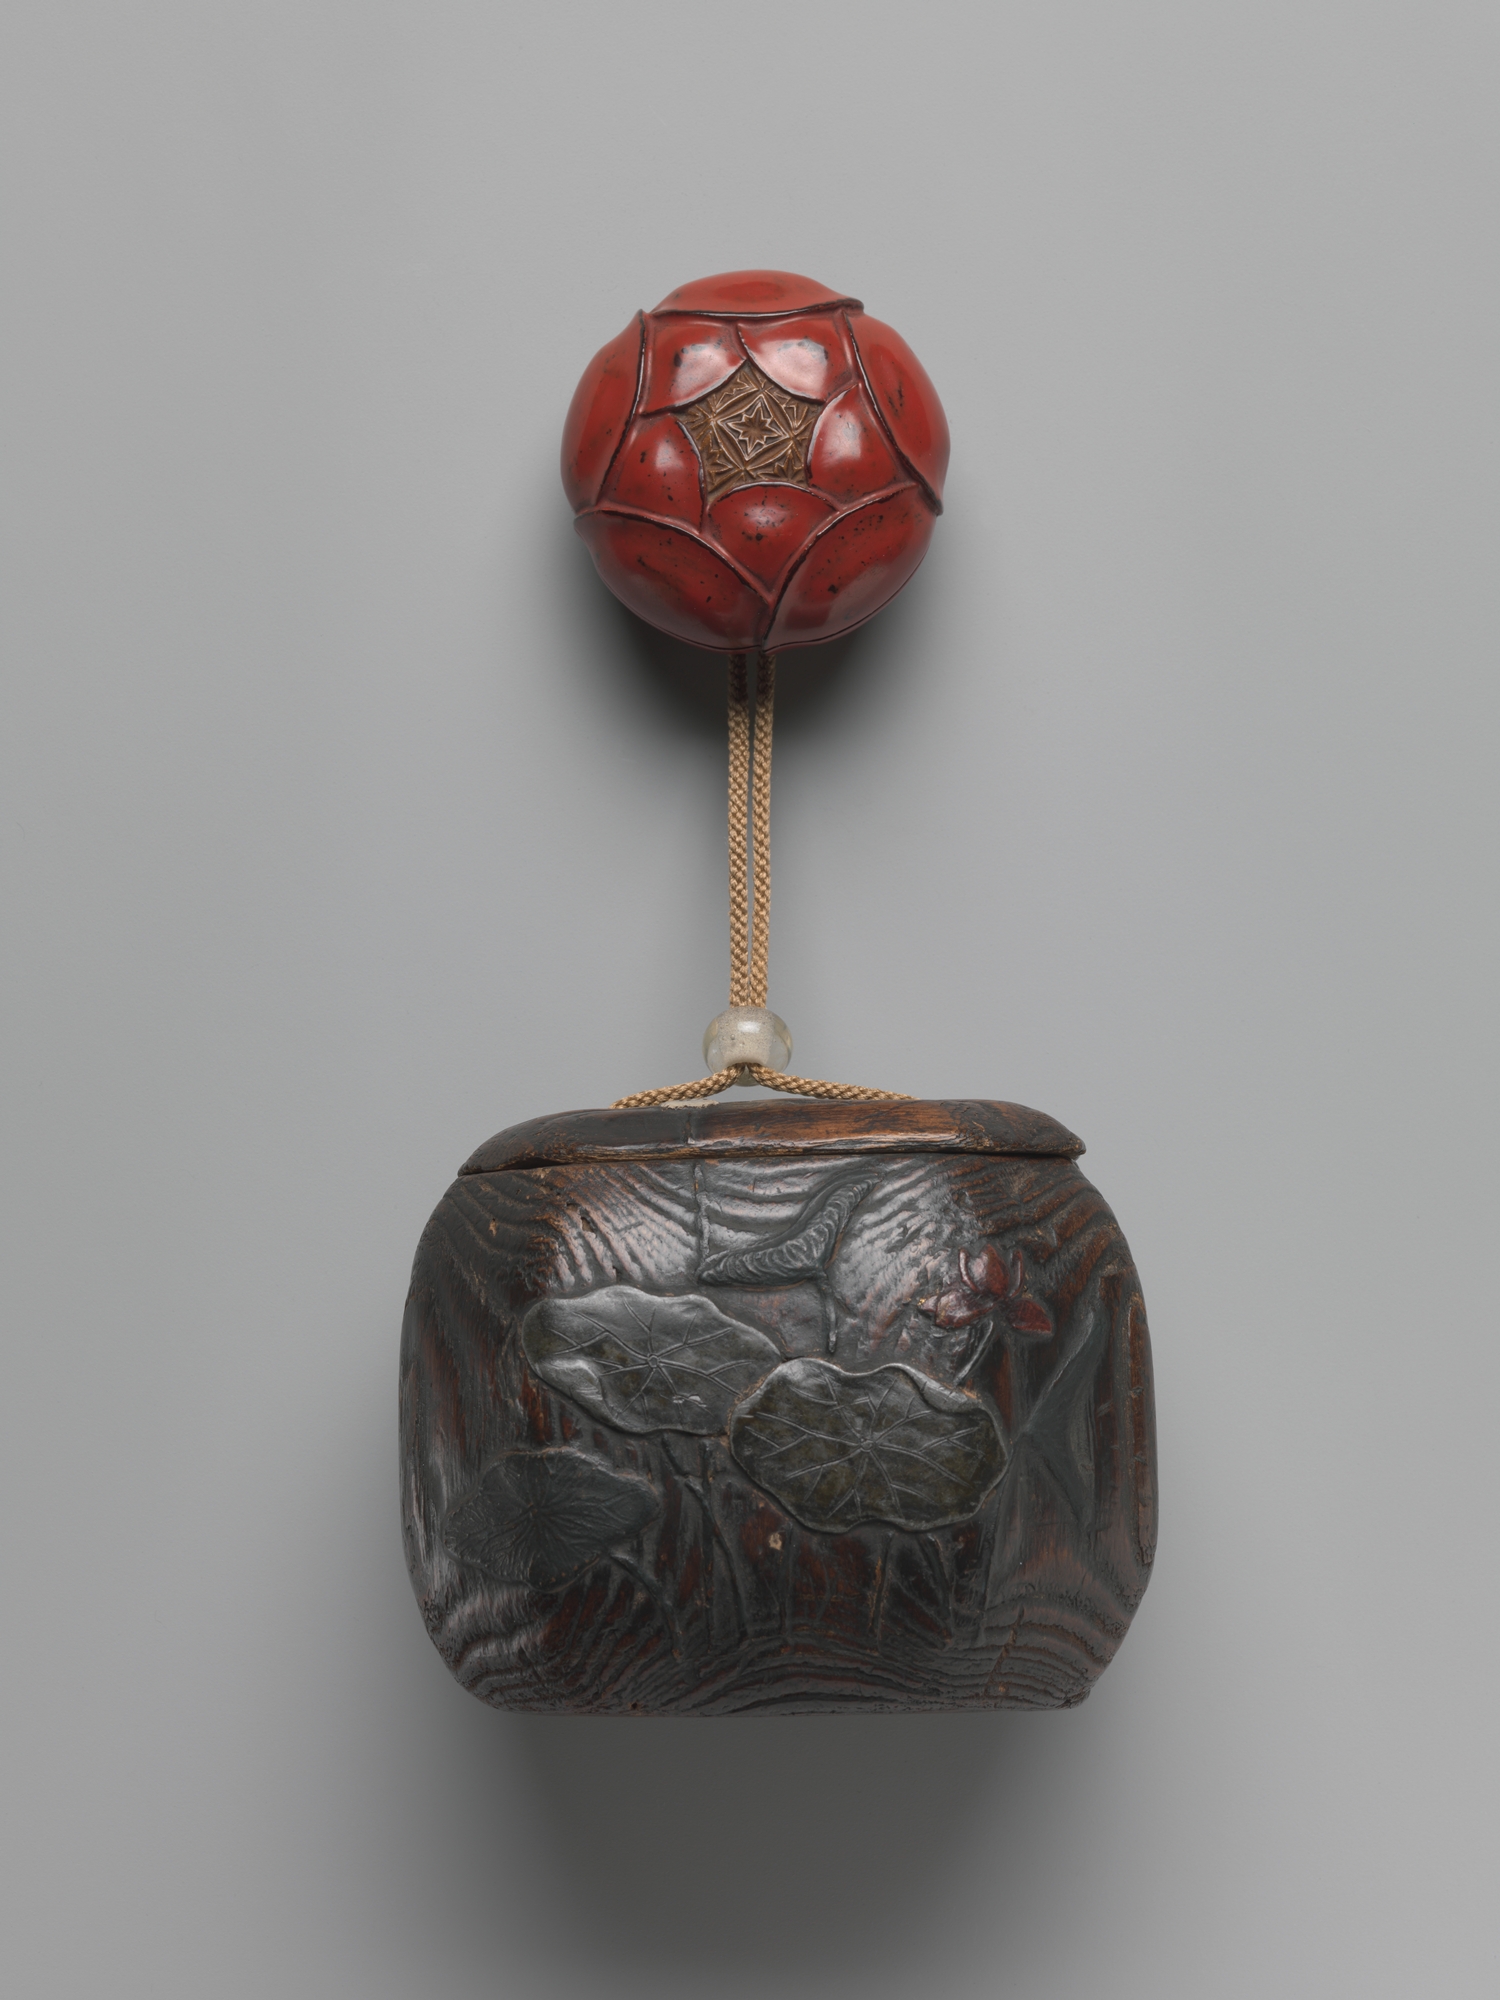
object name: tobacco pouch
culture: japanese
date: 1801-1900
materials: lacquer